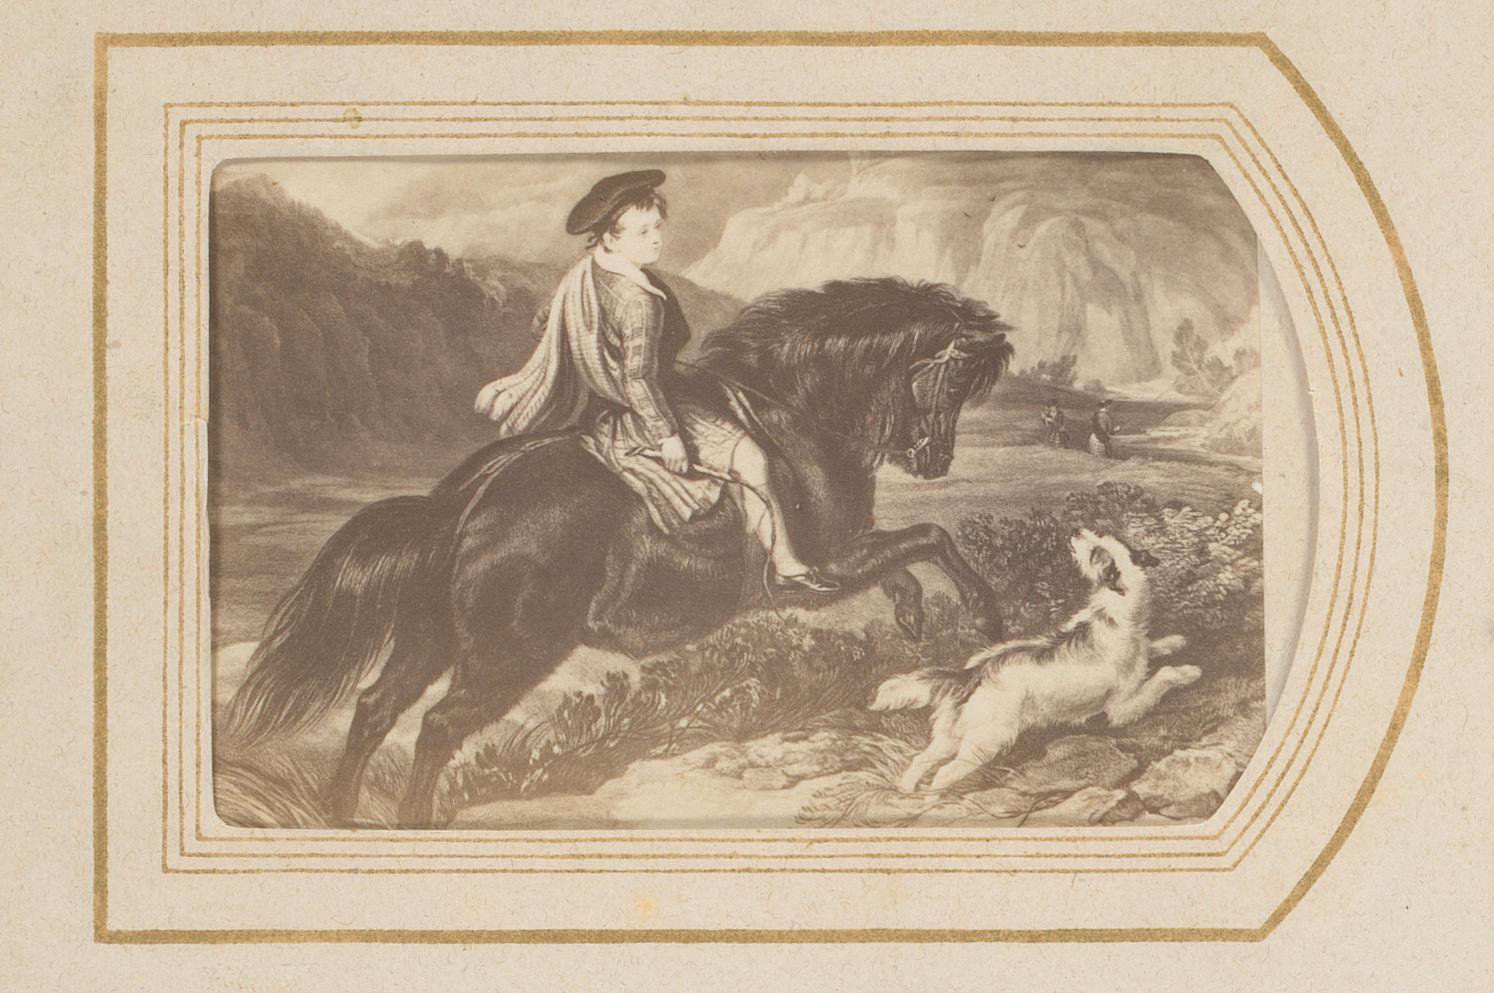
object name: carte de visite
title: Fotoreproductie van Die ersten Reitstudien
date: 1870-1890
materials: cardboard, photographic support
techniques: albumen print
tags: riding a horse, ass, or mule; rider, horseman, dog, painting, drawing and the graphic arts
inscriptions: annotation: ‘Reitstudien’